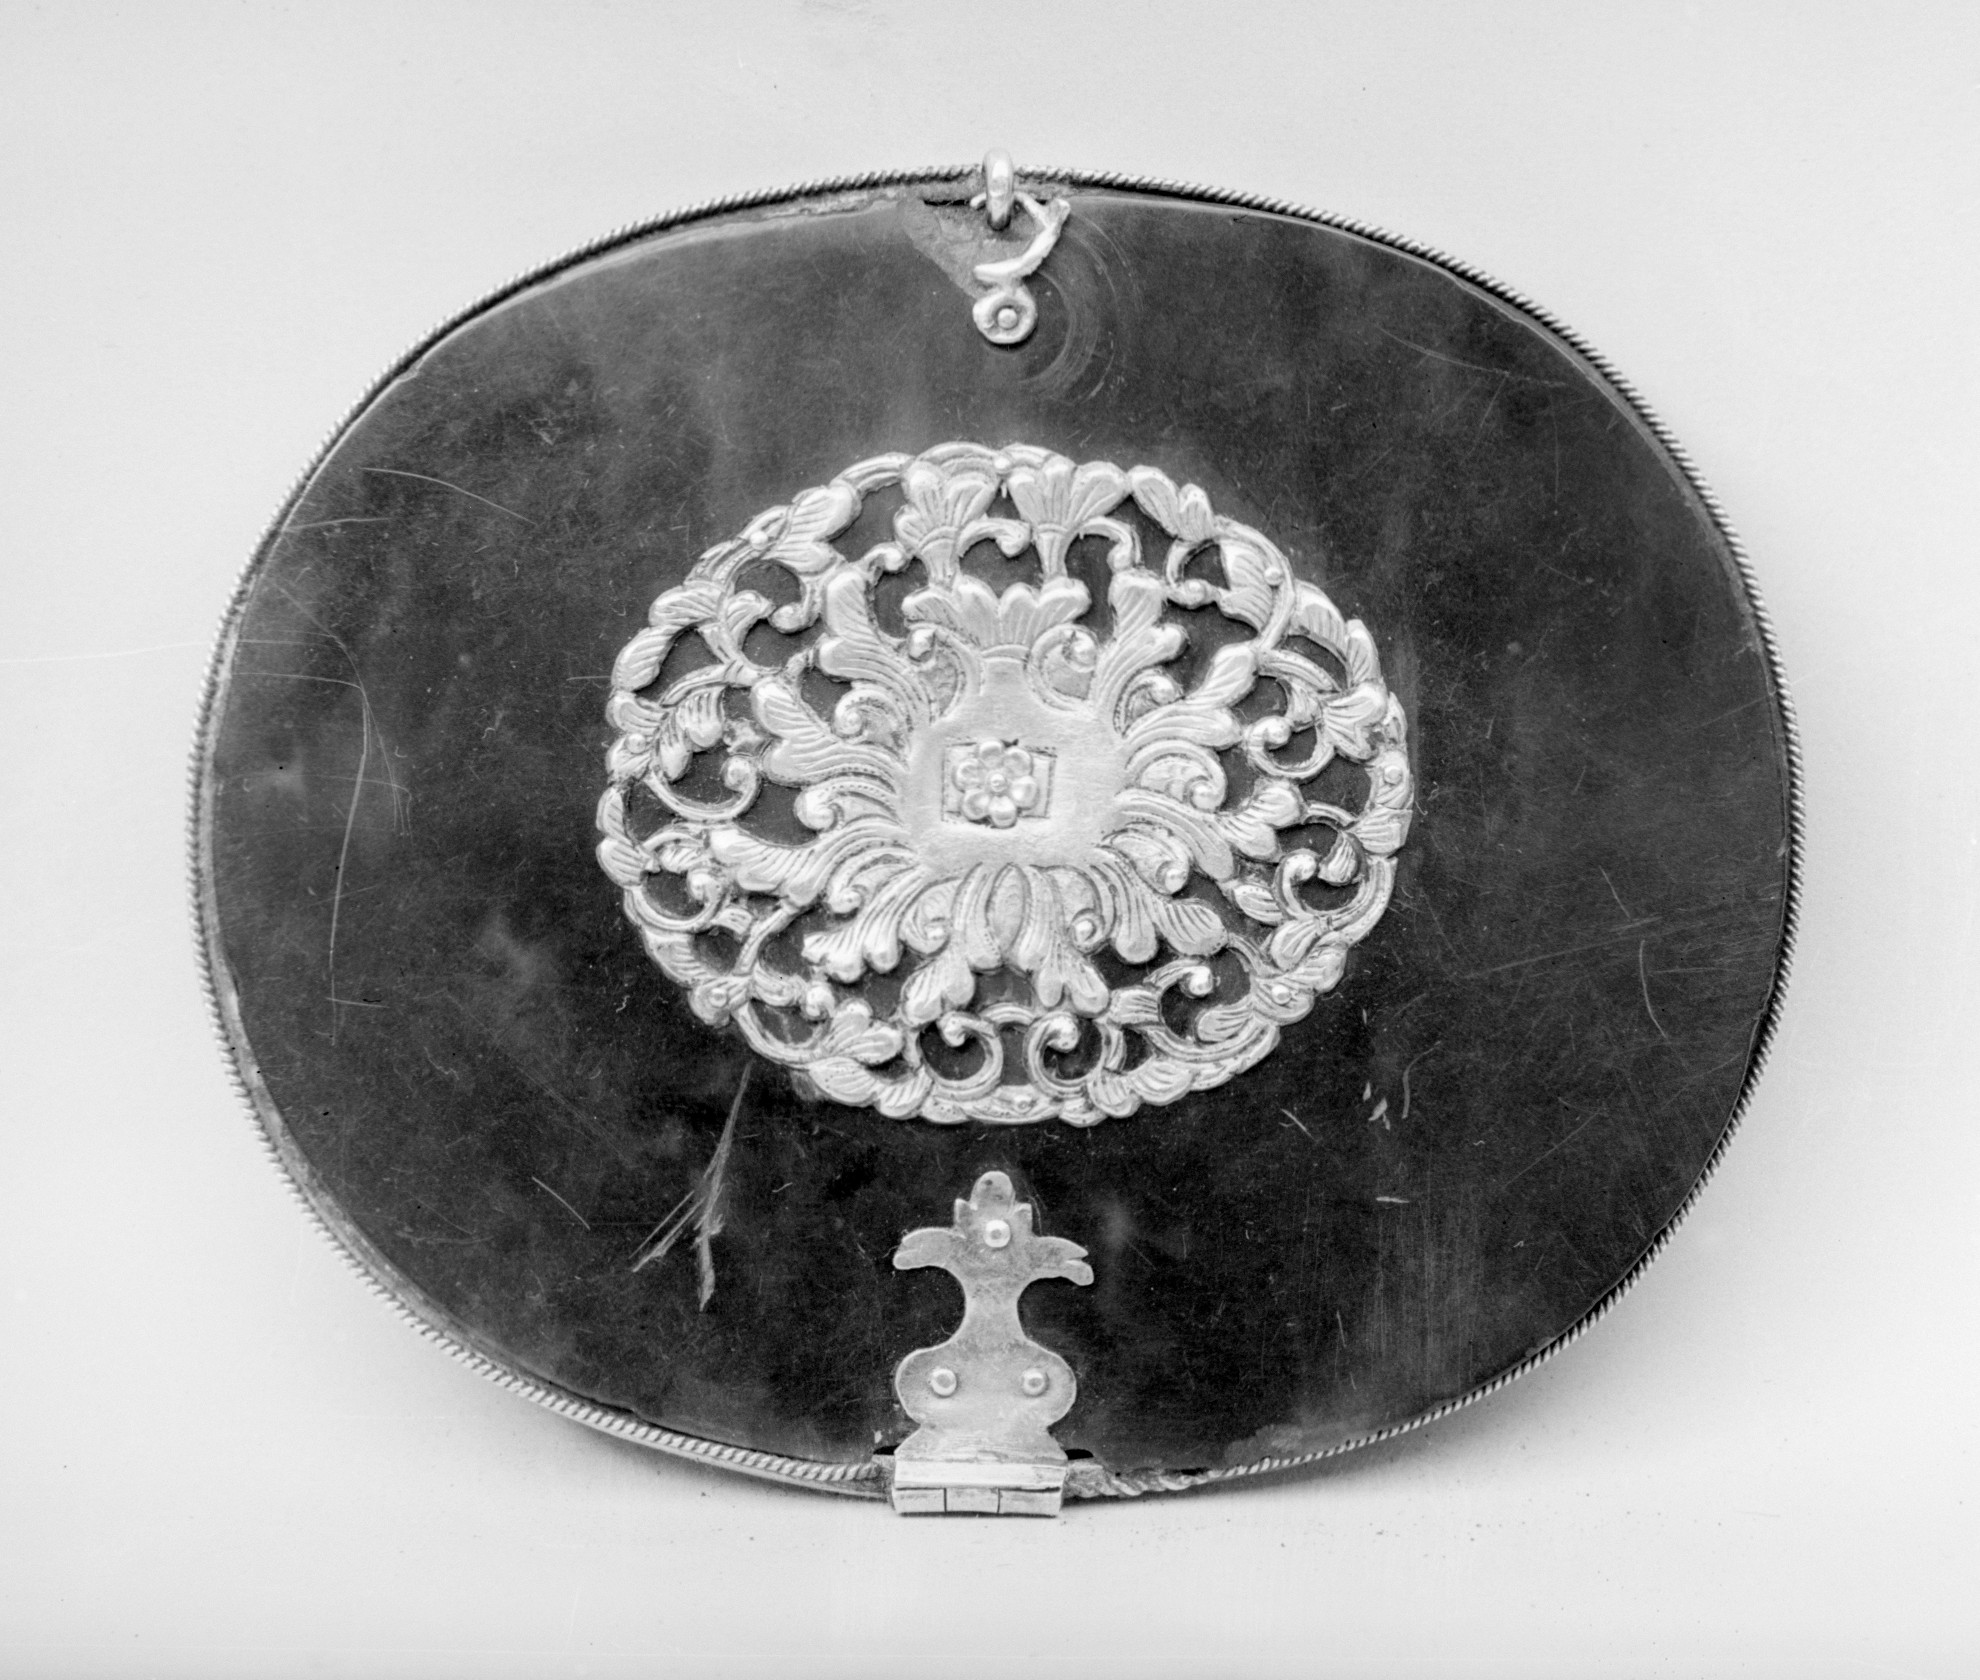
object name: box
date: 1601-1700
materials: silver, shell